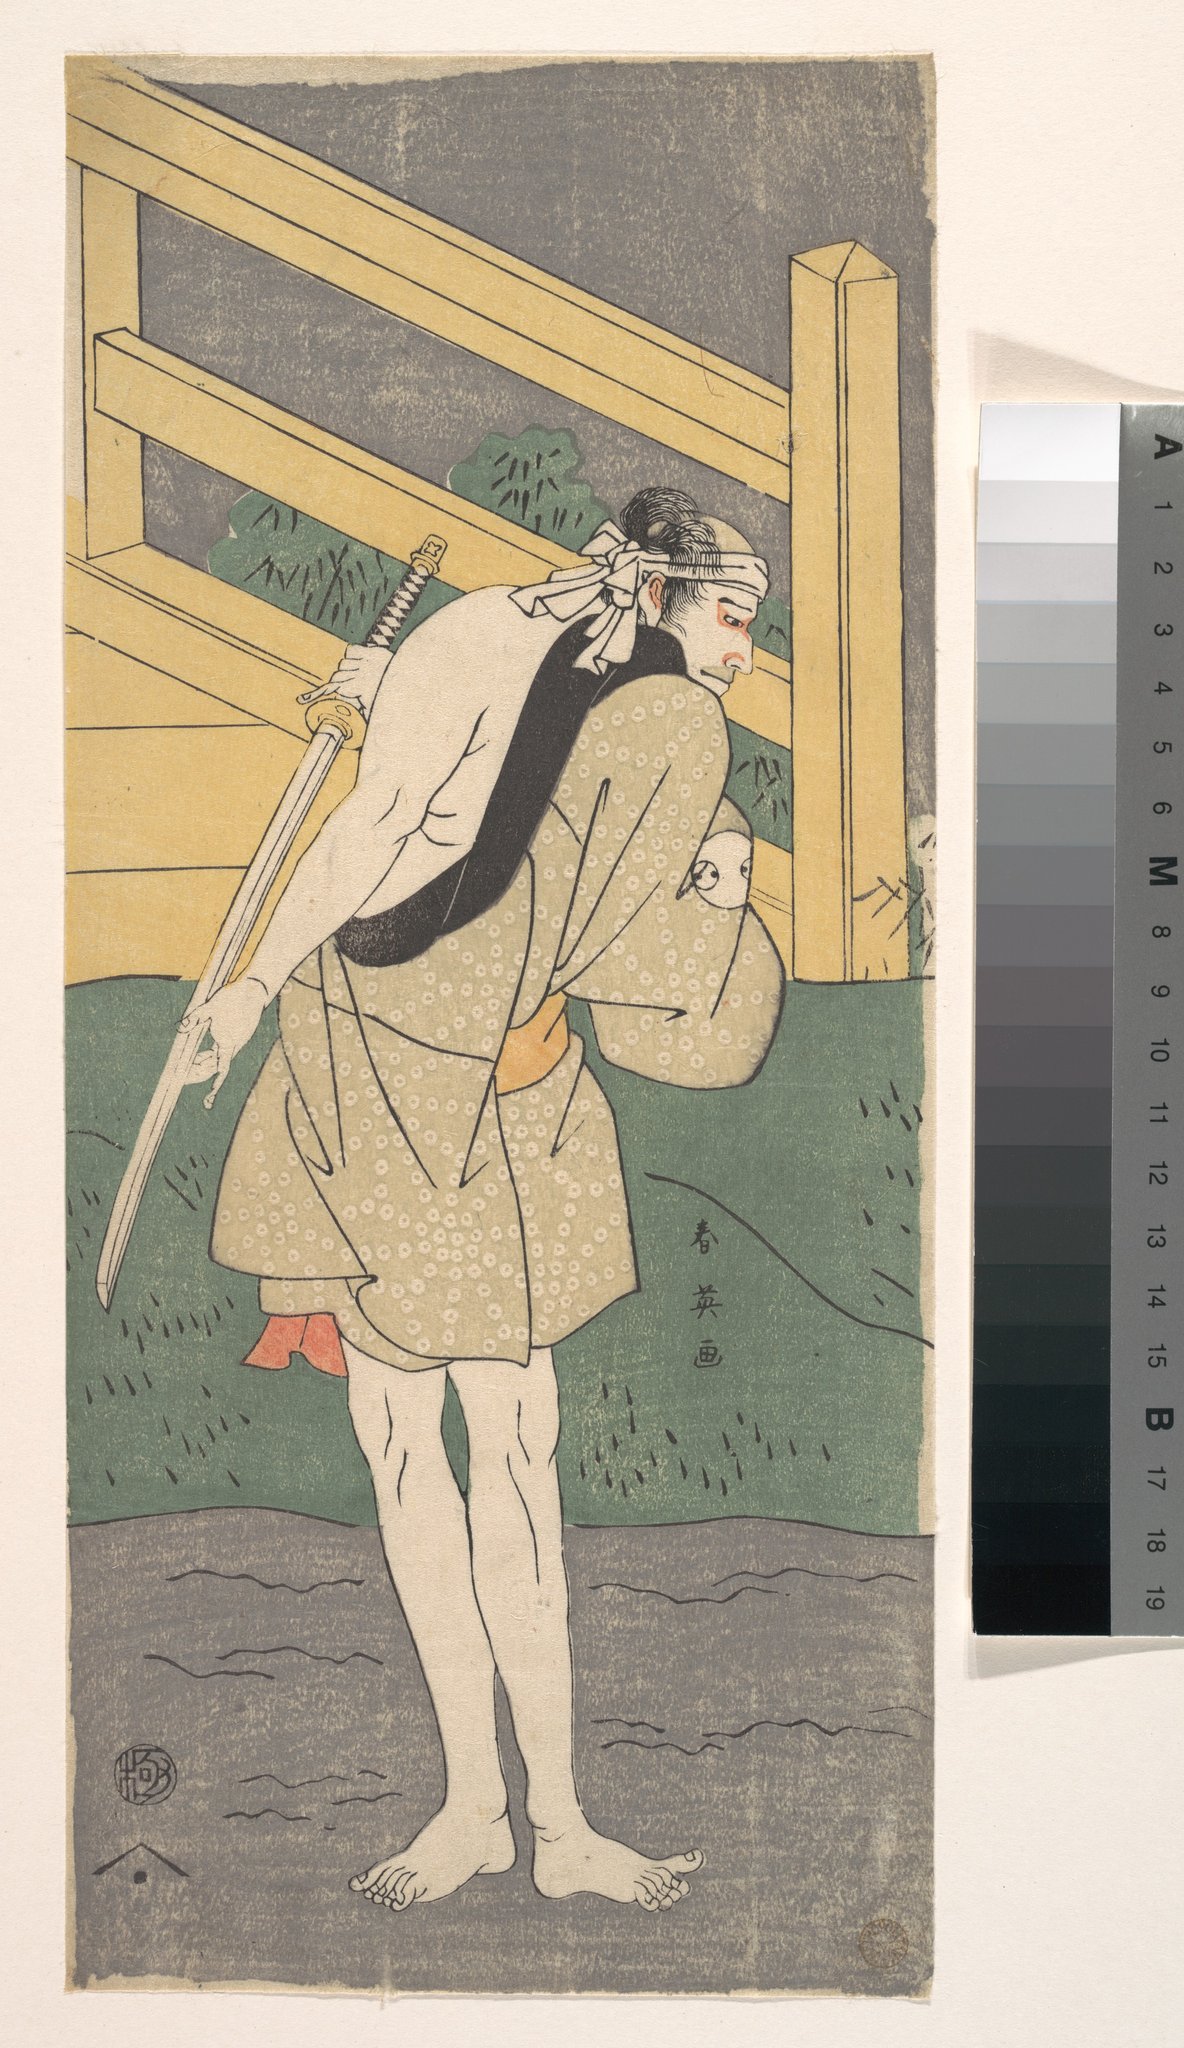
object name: print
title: Arashi Ryuzo as a Man Clad only in a Pale Blue Garment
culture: japanese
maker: katsukawa shun'ei 勝川春英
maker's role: artist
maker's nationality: japanese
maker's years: 1762-1819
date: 1796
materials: ink, paper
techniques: woodblock print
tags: swords,actors